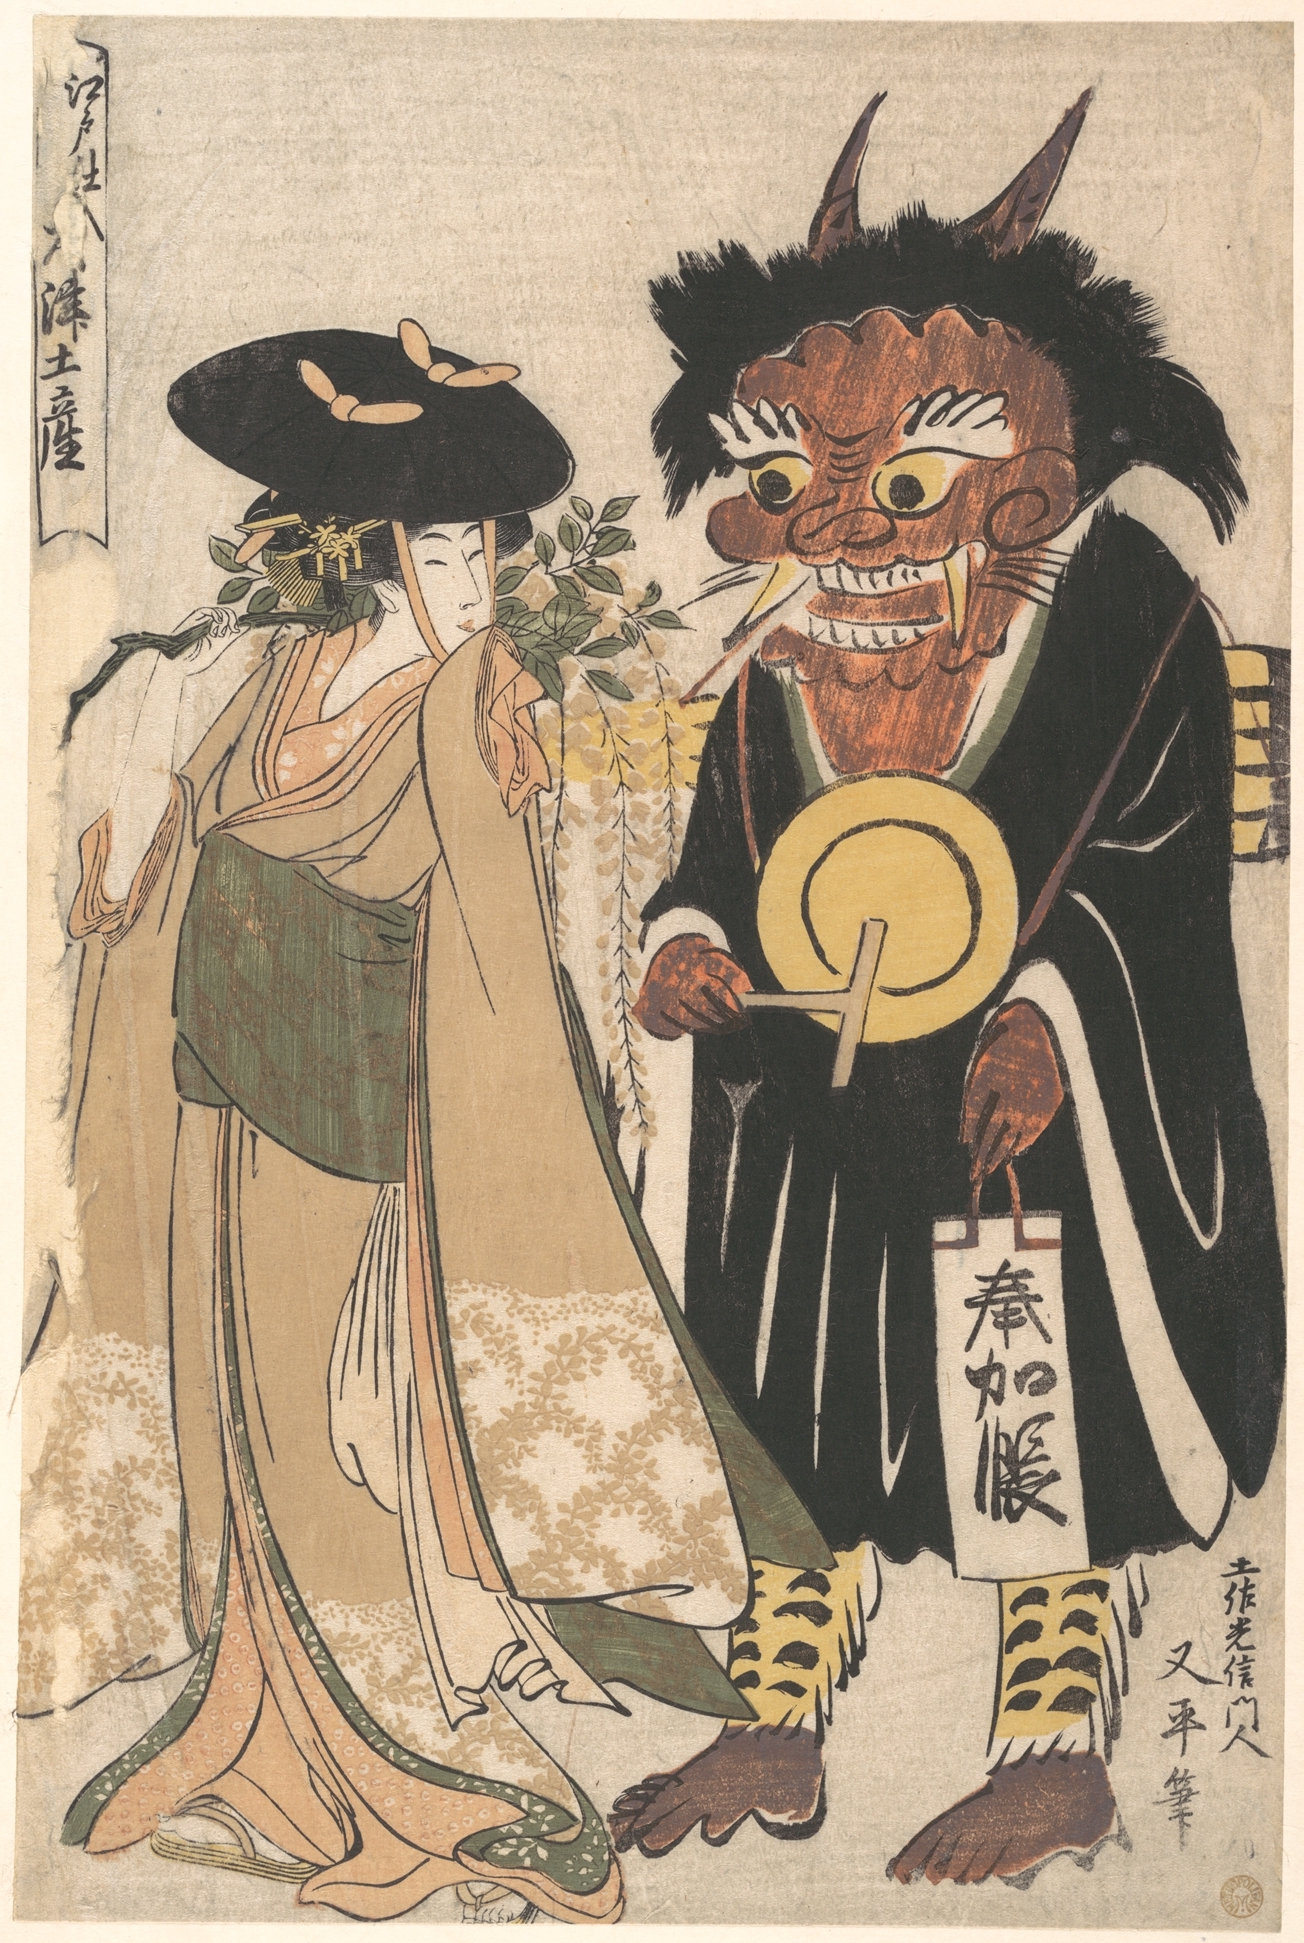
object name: print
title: Young Woman with an Otsue Demon Dressed as an Itinerant Priest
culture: japanese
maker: kitagawa utamaro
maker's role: artist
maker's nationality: japanese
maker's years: 1754-1806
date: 1804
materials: ink, paper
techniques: woodblock print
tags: women,demons